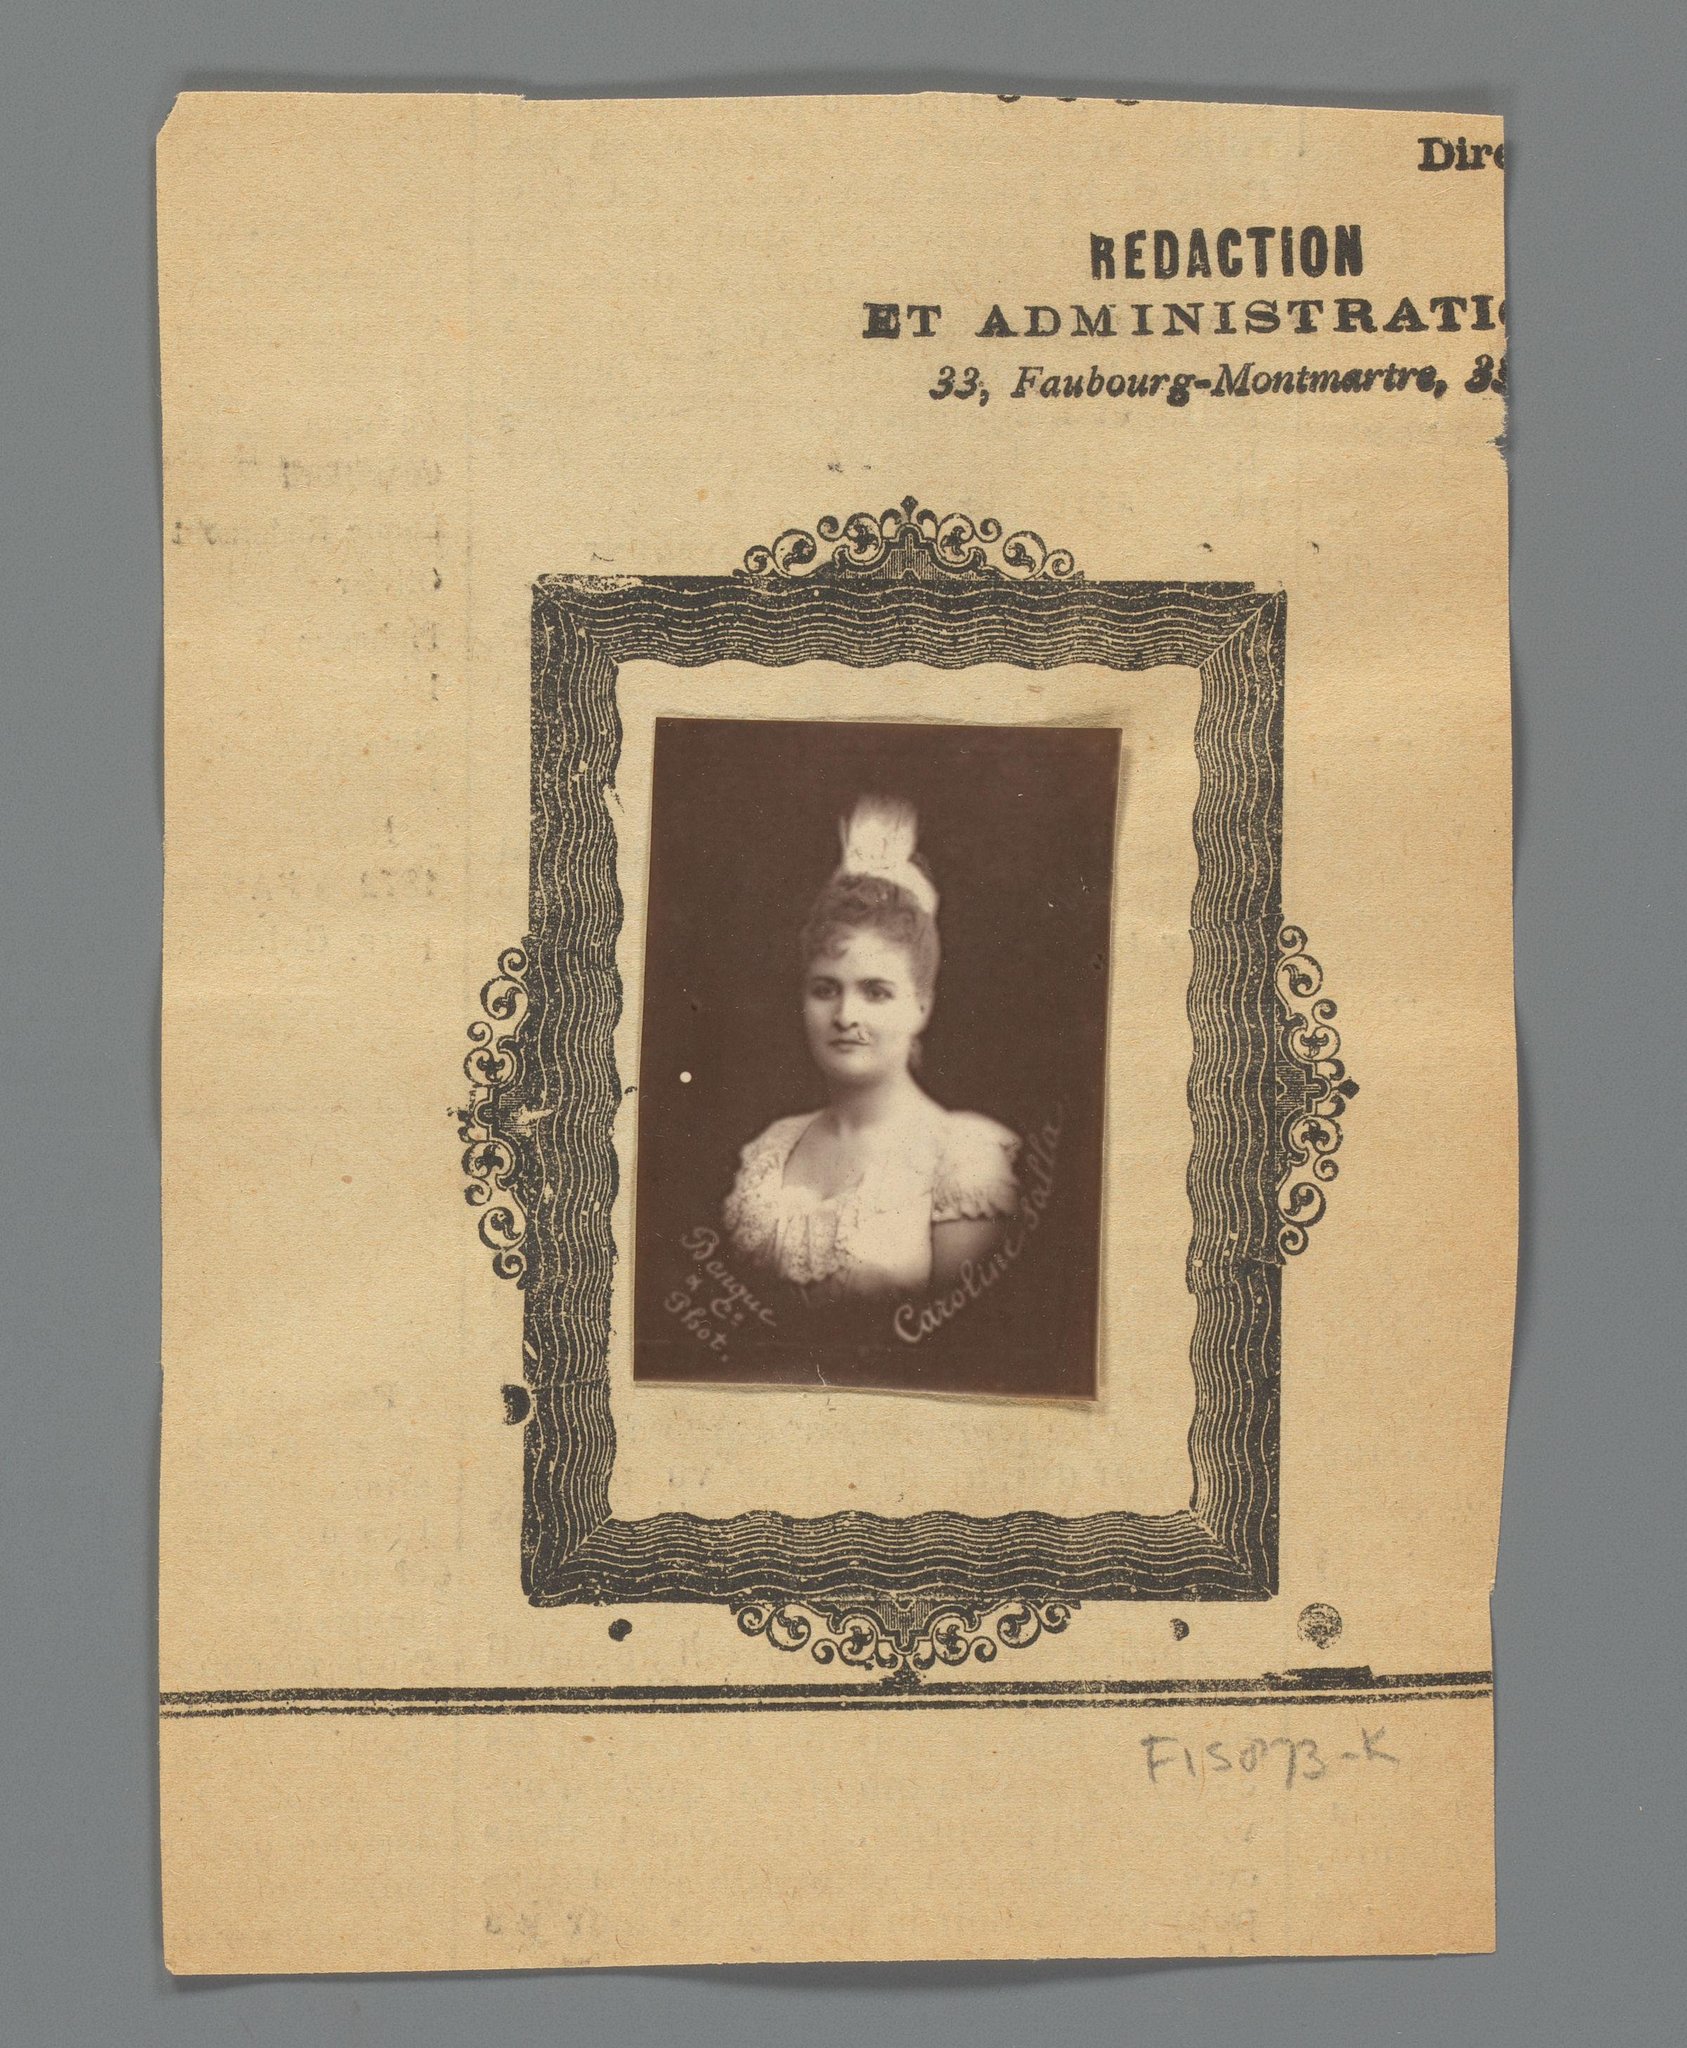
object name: photograph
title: Portret van Caroline Salla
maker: wilhelm benque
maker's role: fotograaf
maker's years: 1843-1903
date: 1890-1910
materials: paper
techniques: albumen print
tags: portrait of opera-singer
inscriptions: inscription: ‘Bengue/ & Cie/ Phot./ Caroline-Salla’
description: Knipsel uit 'Les Folies-Bergèr, journal spécial au théâtre' met een opgeplakt fotoportret.